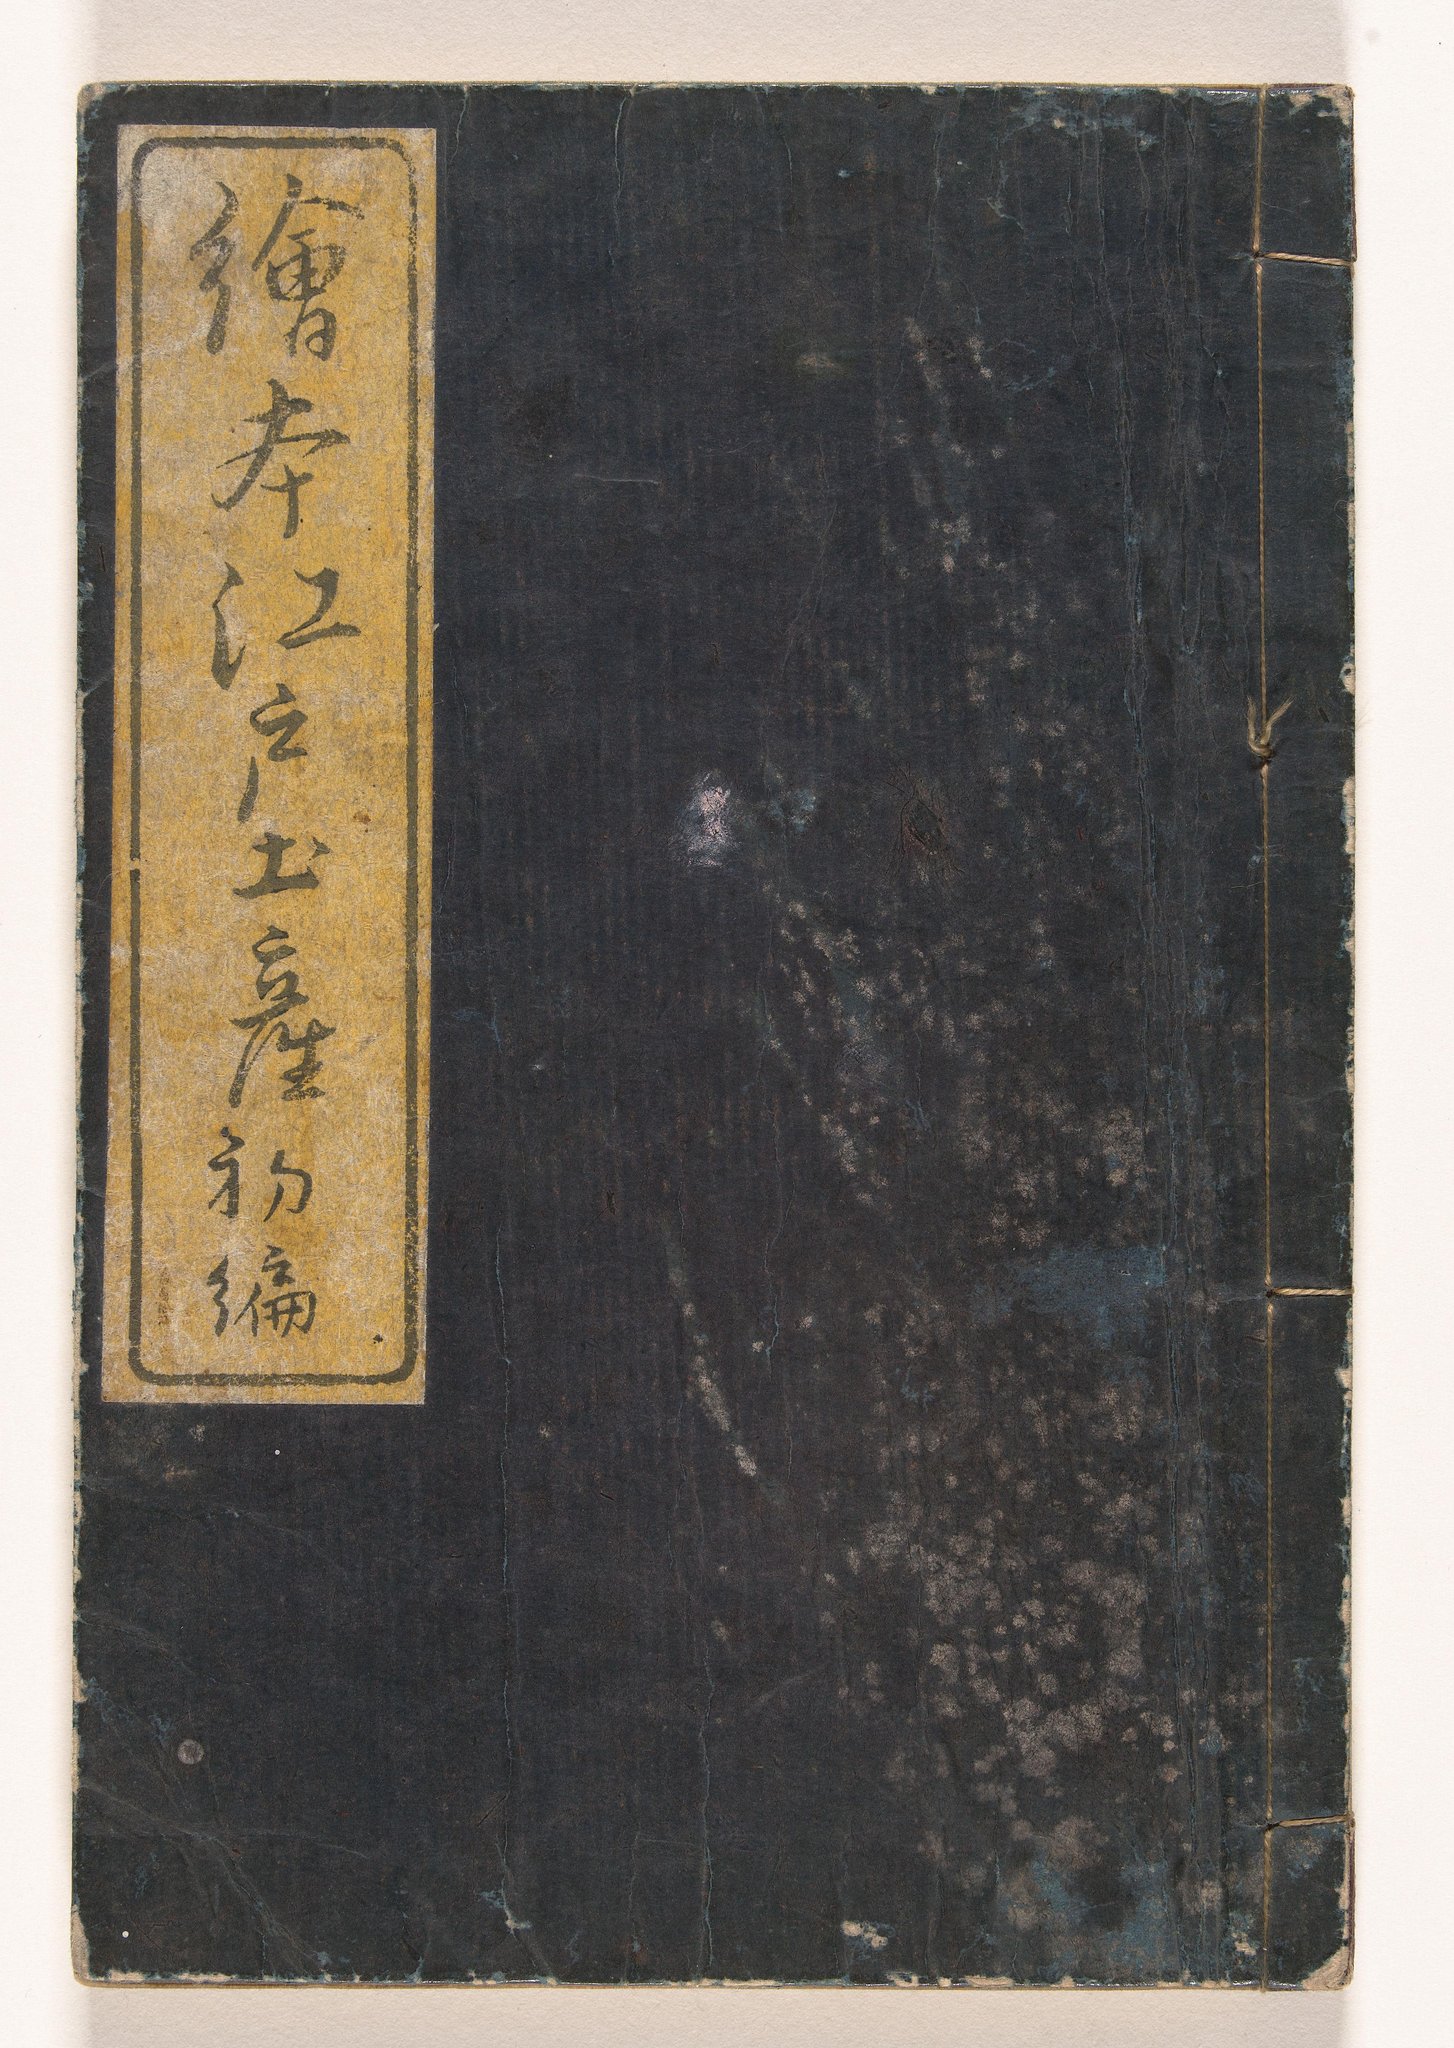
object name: book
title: Ehon Edo miyage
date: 1850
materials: paper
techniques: woodcut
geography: edo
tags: edo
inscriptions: date